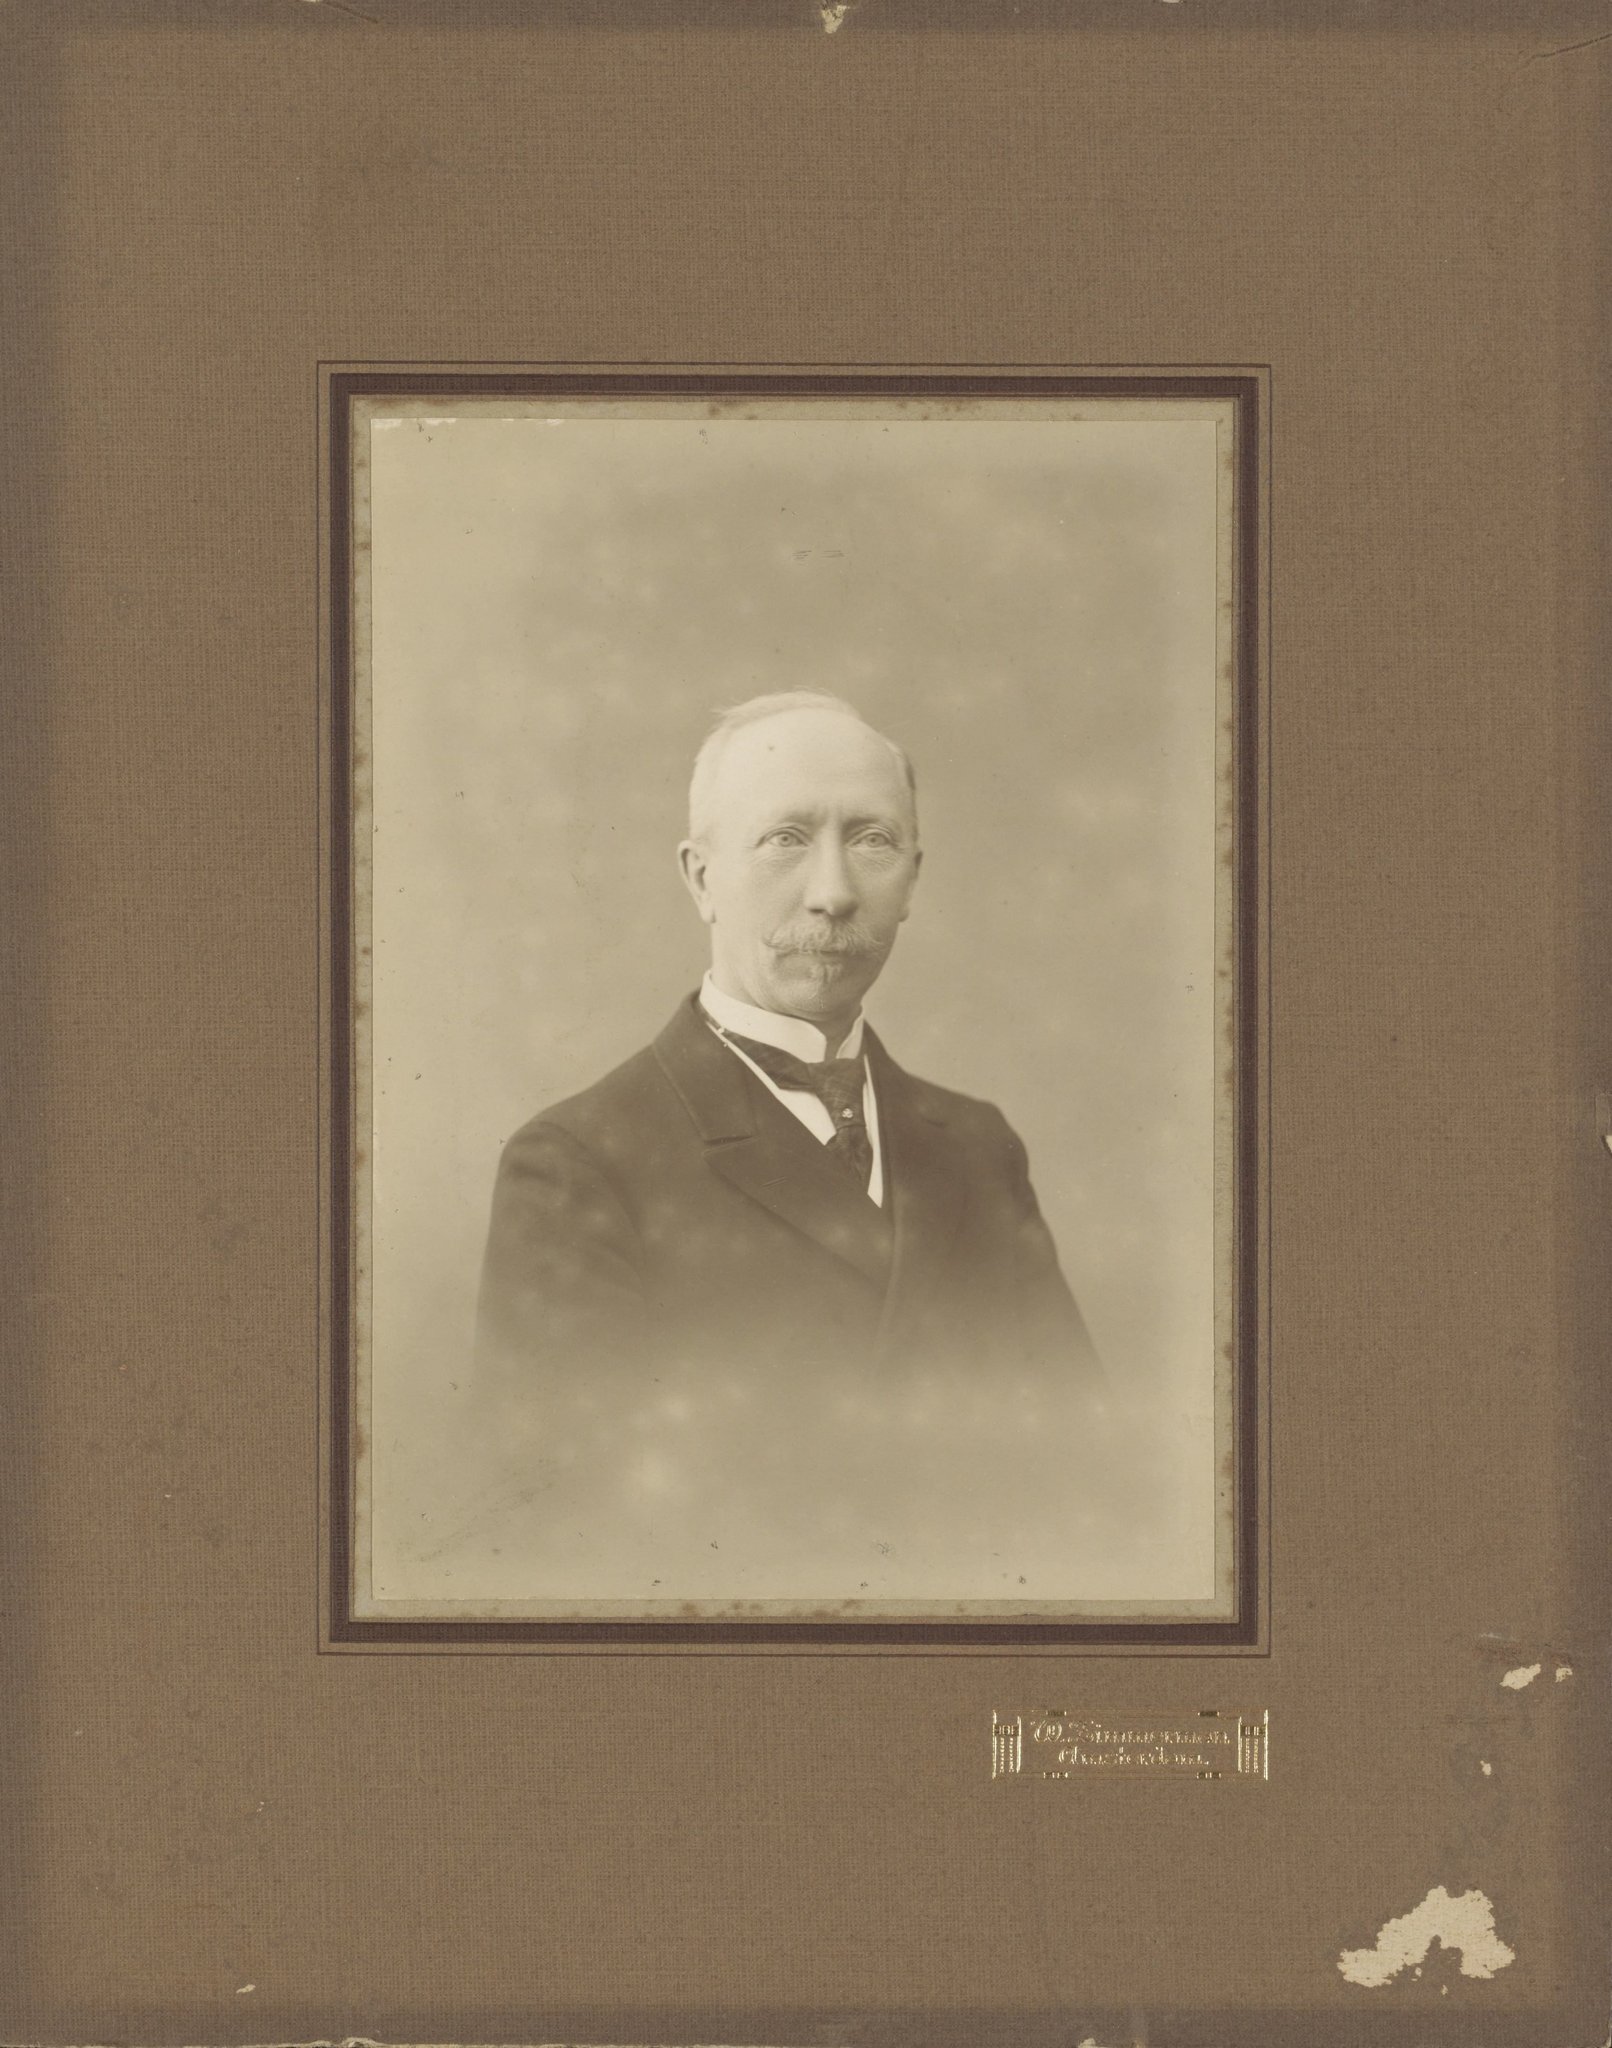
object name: photograph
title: Portret van een man met een stropdas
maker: guillame maximilien zimmermann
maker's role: fotograaf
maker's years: 1873-1951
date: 1916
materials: cardboard, paper, photographic support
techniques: daylight paper print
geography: amsterdam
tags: adult man, neck-gear ~ clothing, amsterdam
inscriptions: inscription: ‘9091 Vrijdag’, name: ‘W. Zimmerman Amsterdam’, date: ‘1916’